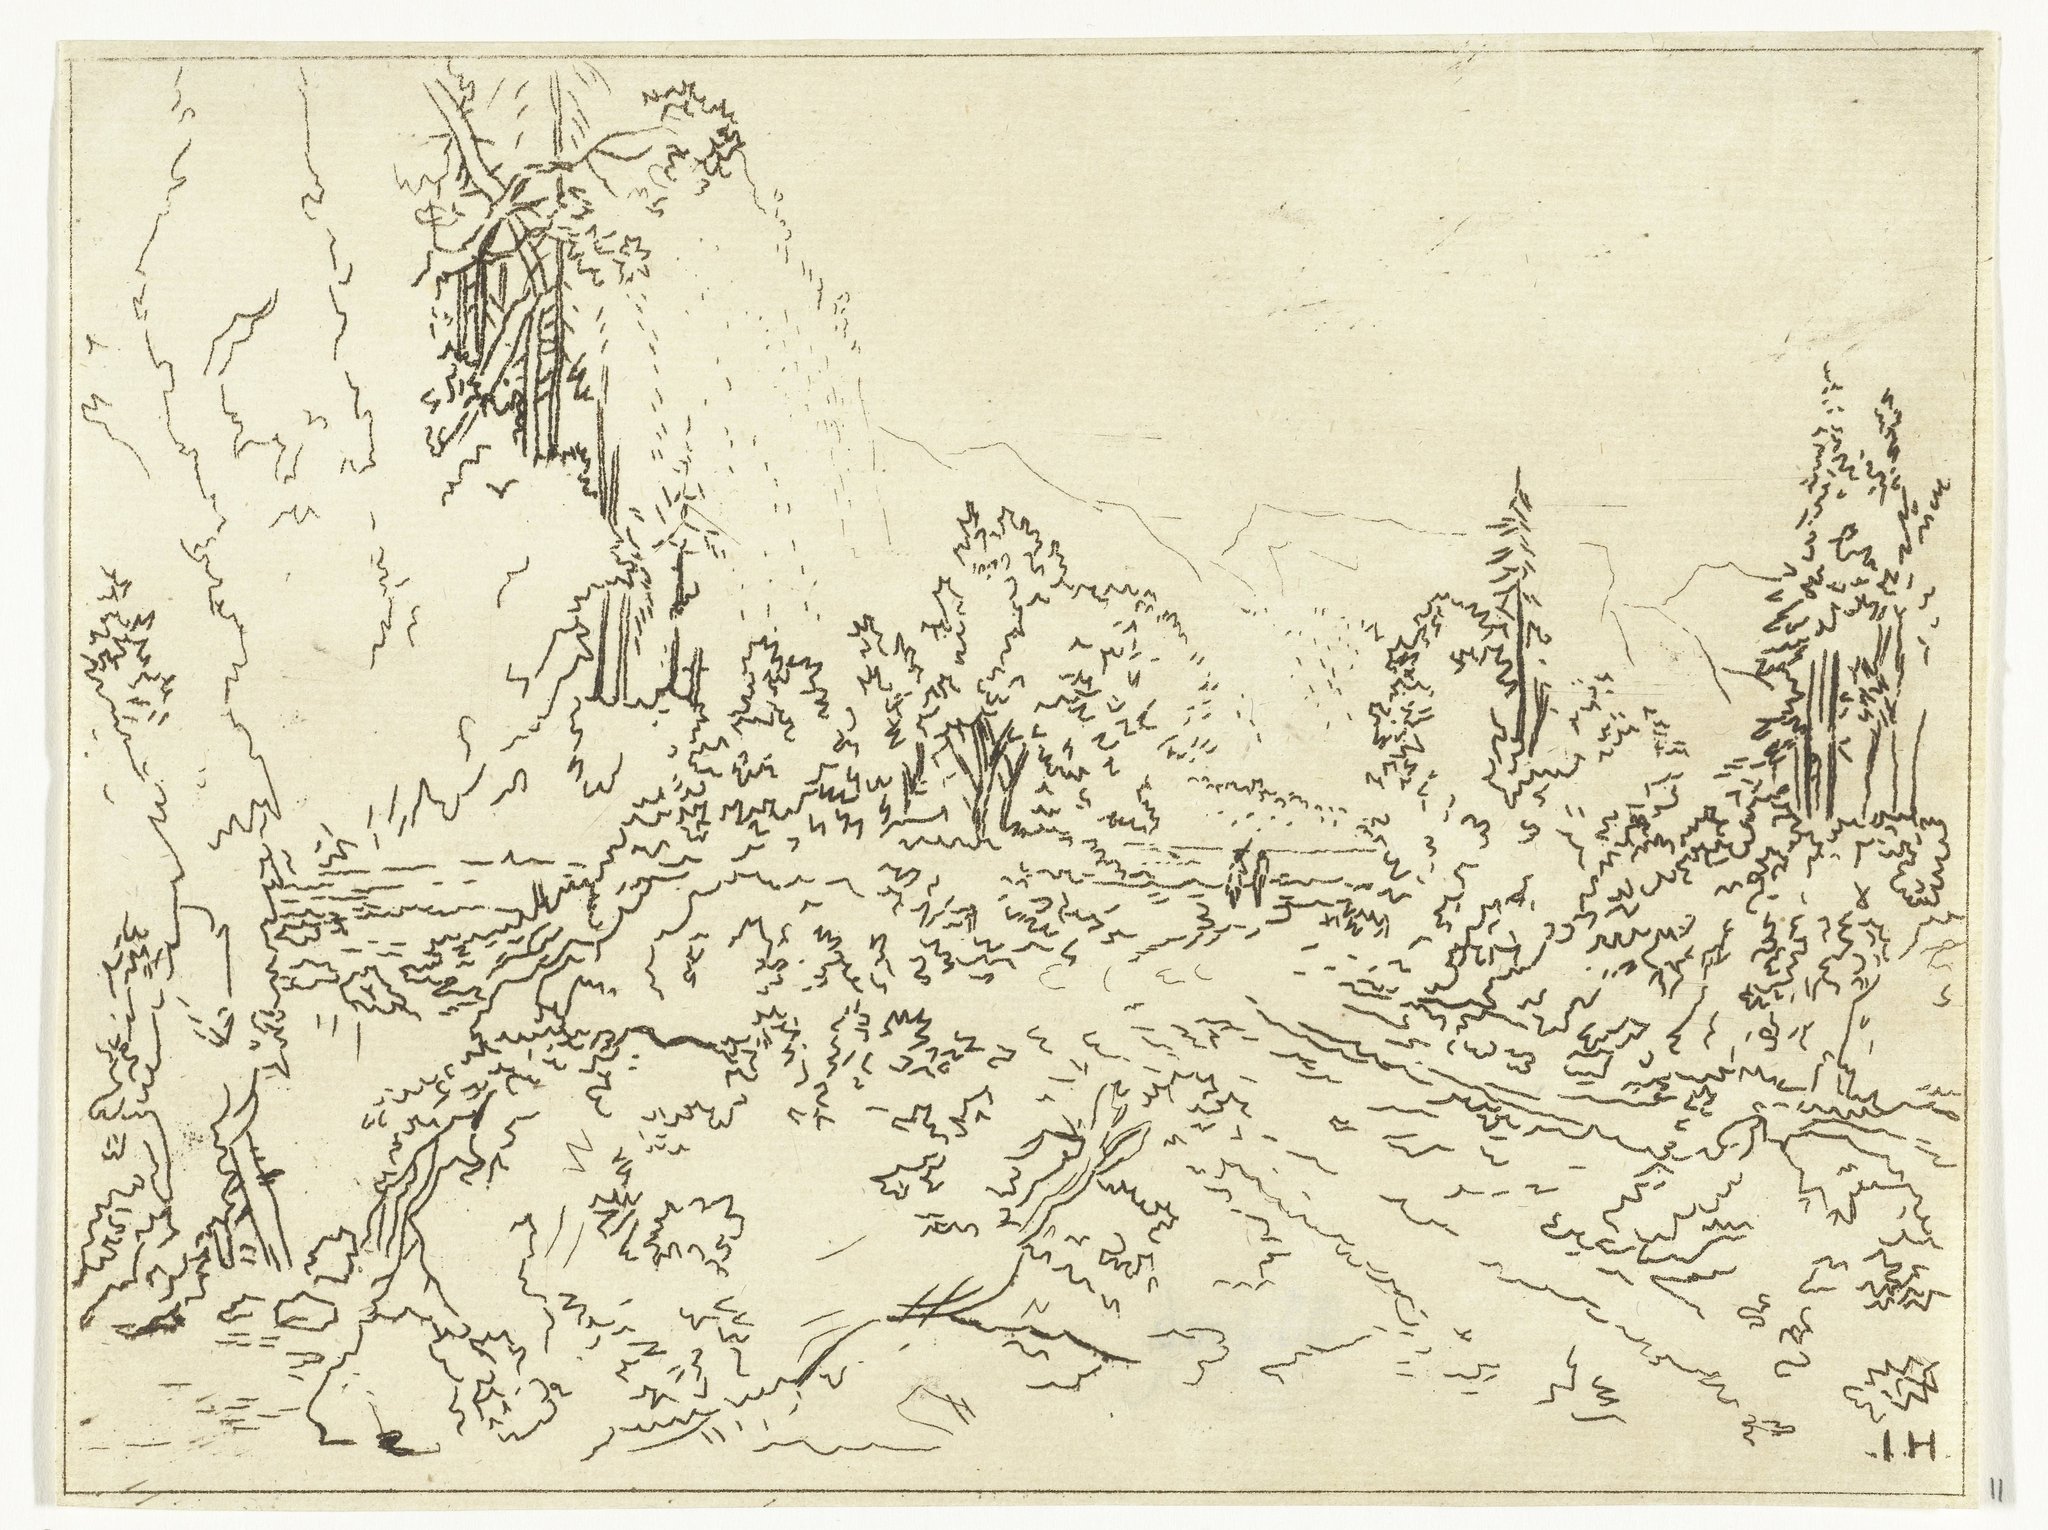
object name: print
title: Bergachtig landschap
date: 1778-1838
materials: paper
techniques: etching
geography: netherlands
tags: waterfall, dale, valley (+ landscape with figures, staffage)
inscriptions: collector's mark: Lugt 2228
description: Twee wandelaars lopen op een weg door een valei. Links een waterval.